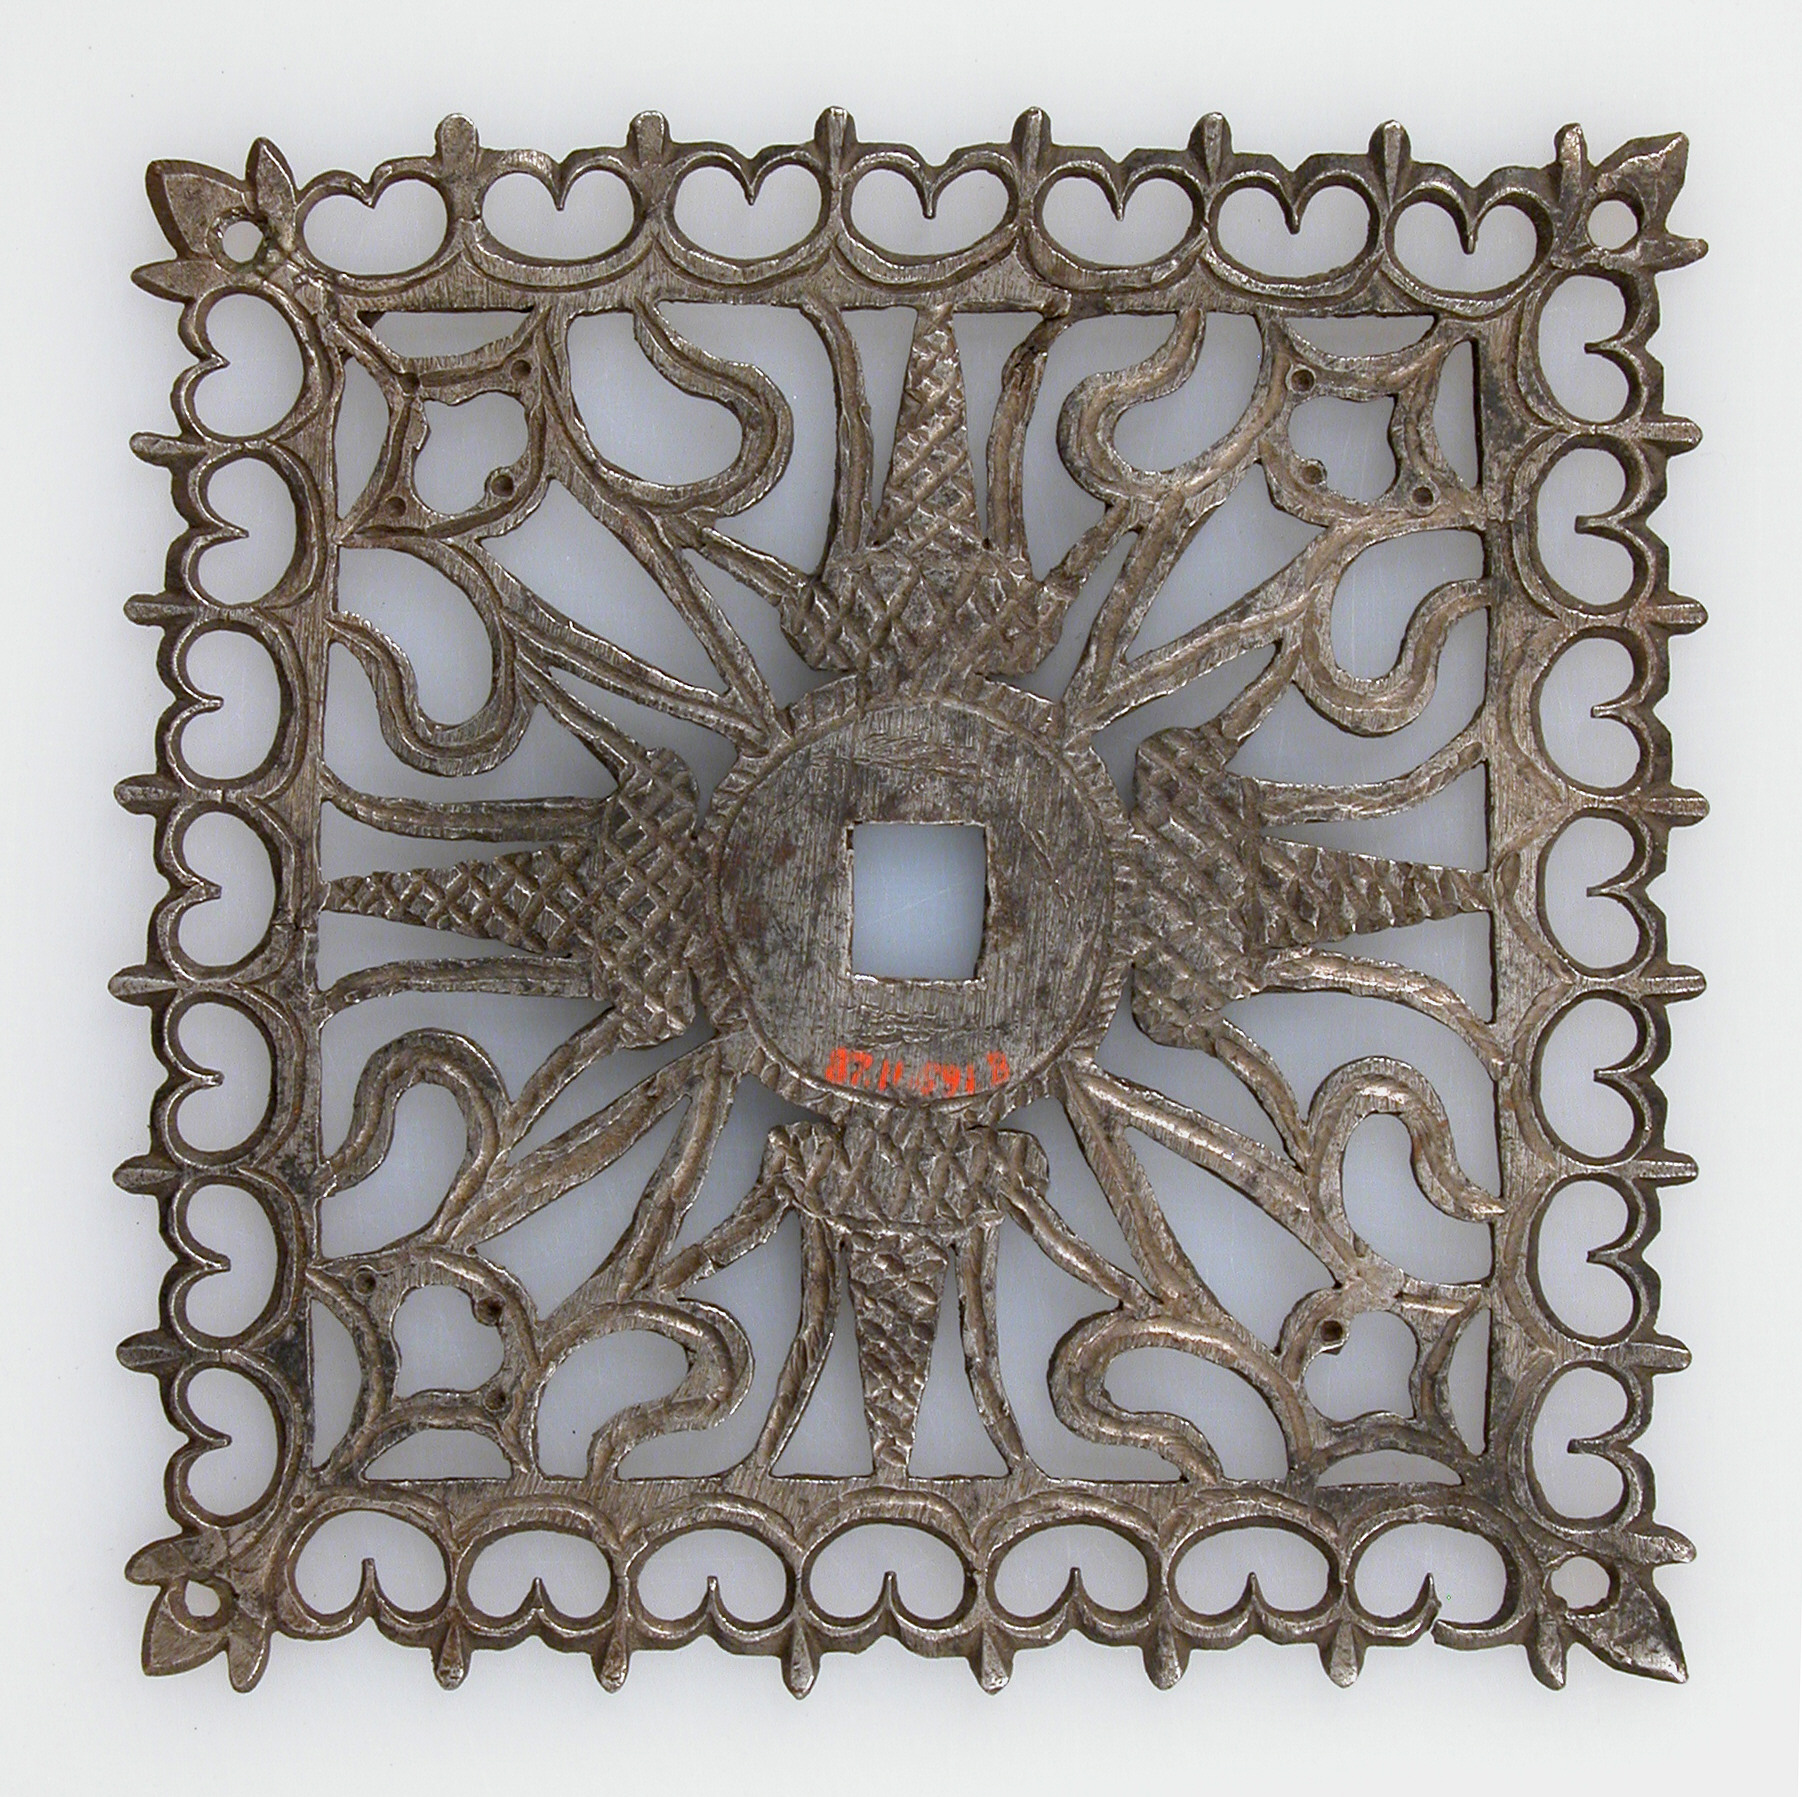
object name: door plate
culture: german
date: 1501-1600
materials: iron